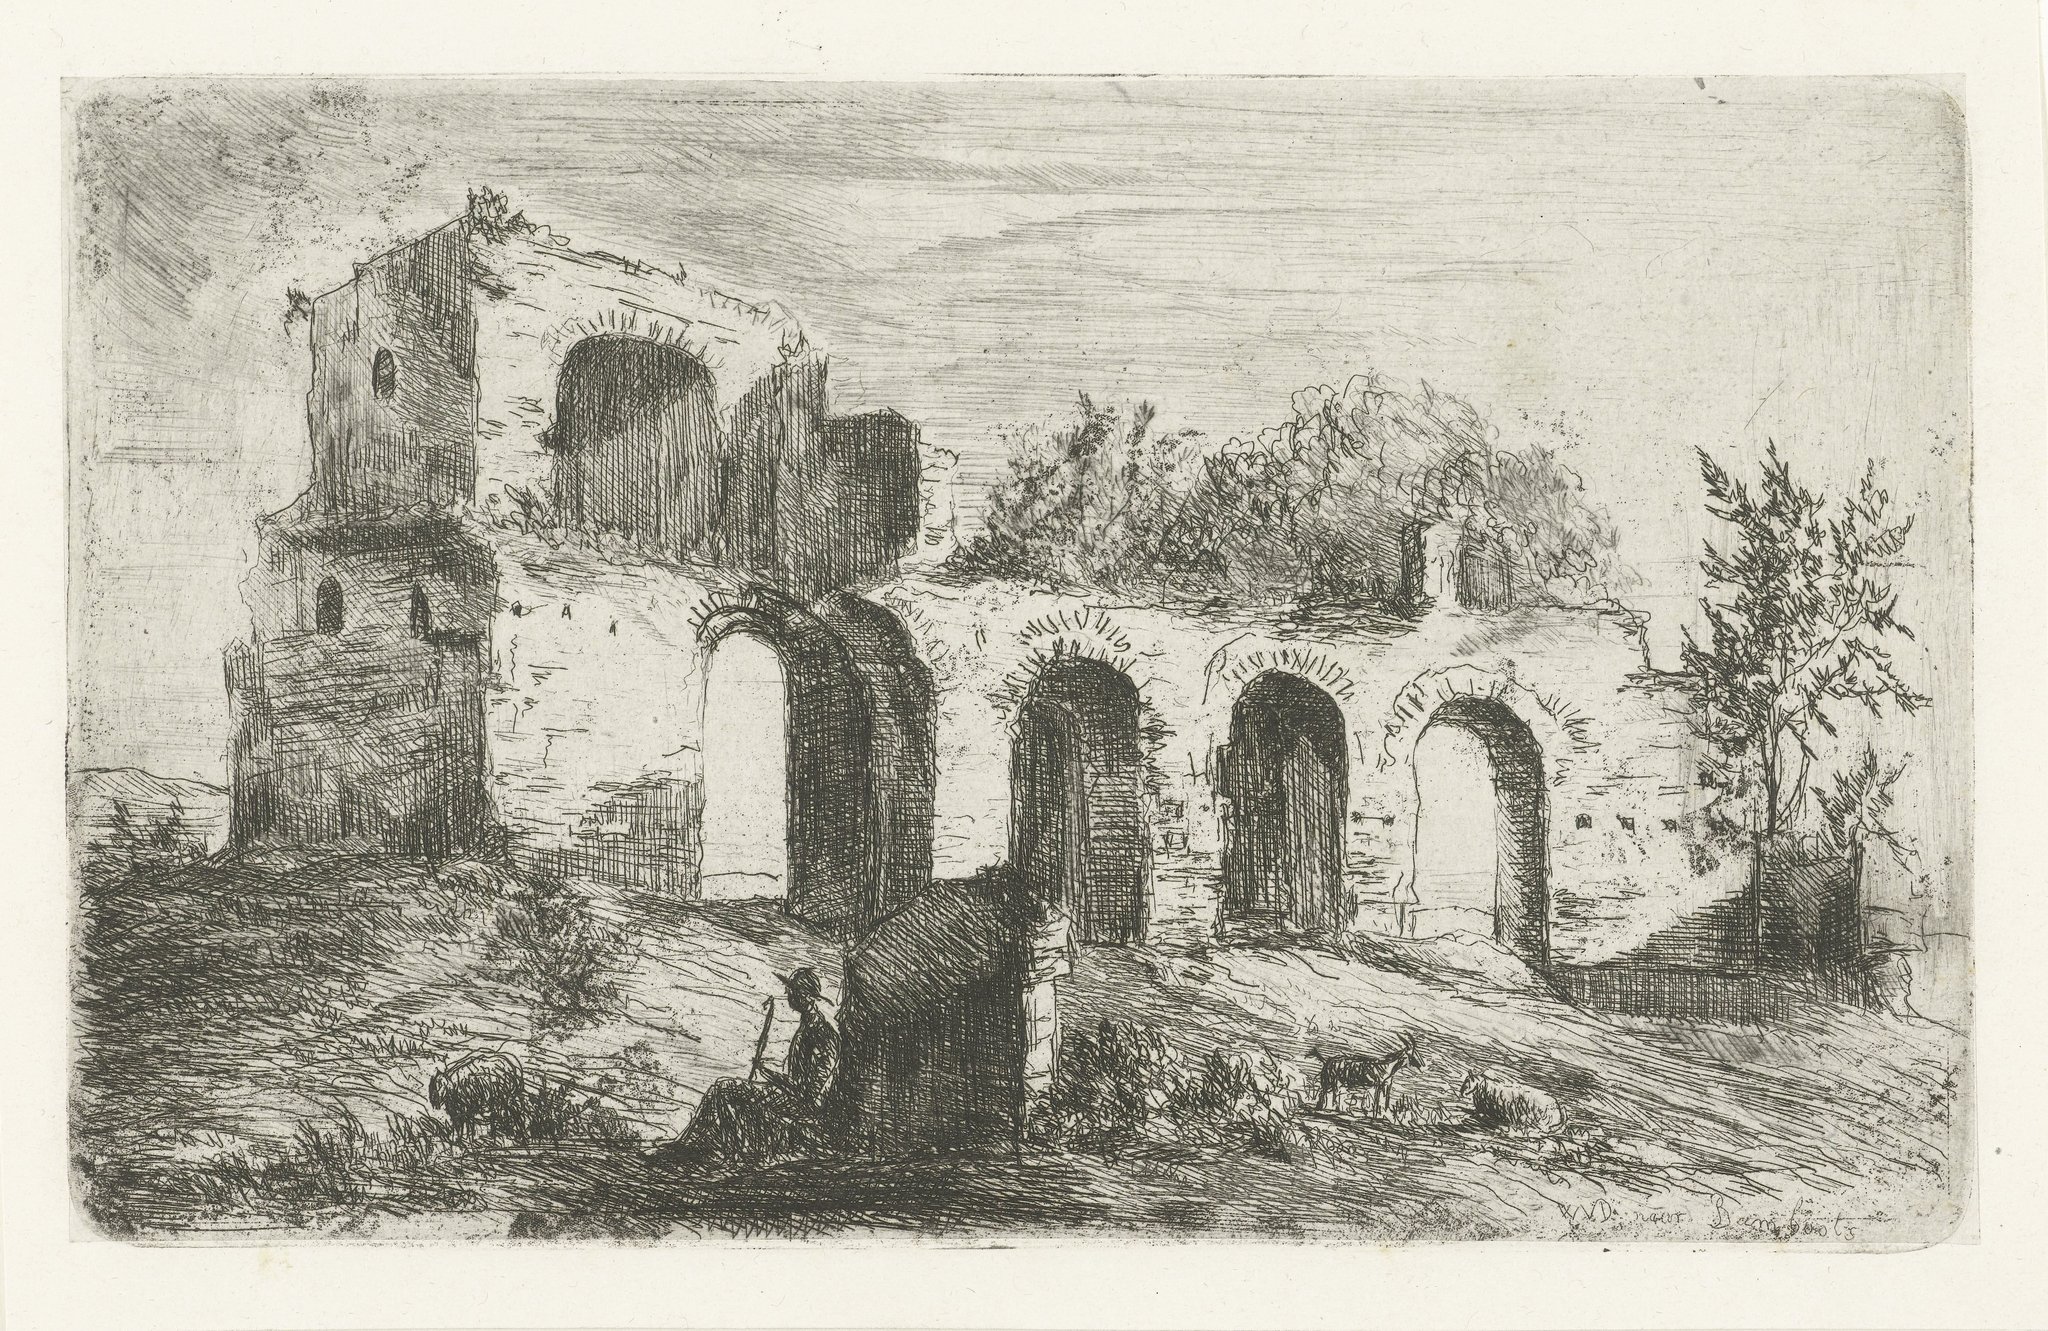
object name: print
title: Zuidelijk landschap met ruïne en herder met vee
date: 1815-1867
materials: paper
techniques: etching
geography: netherlands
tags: herding, herdsman, herdswoman, shepherd, shepherdess, cowherd, etc., landscape with ruins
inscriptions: collector's mark: Lugt 2228